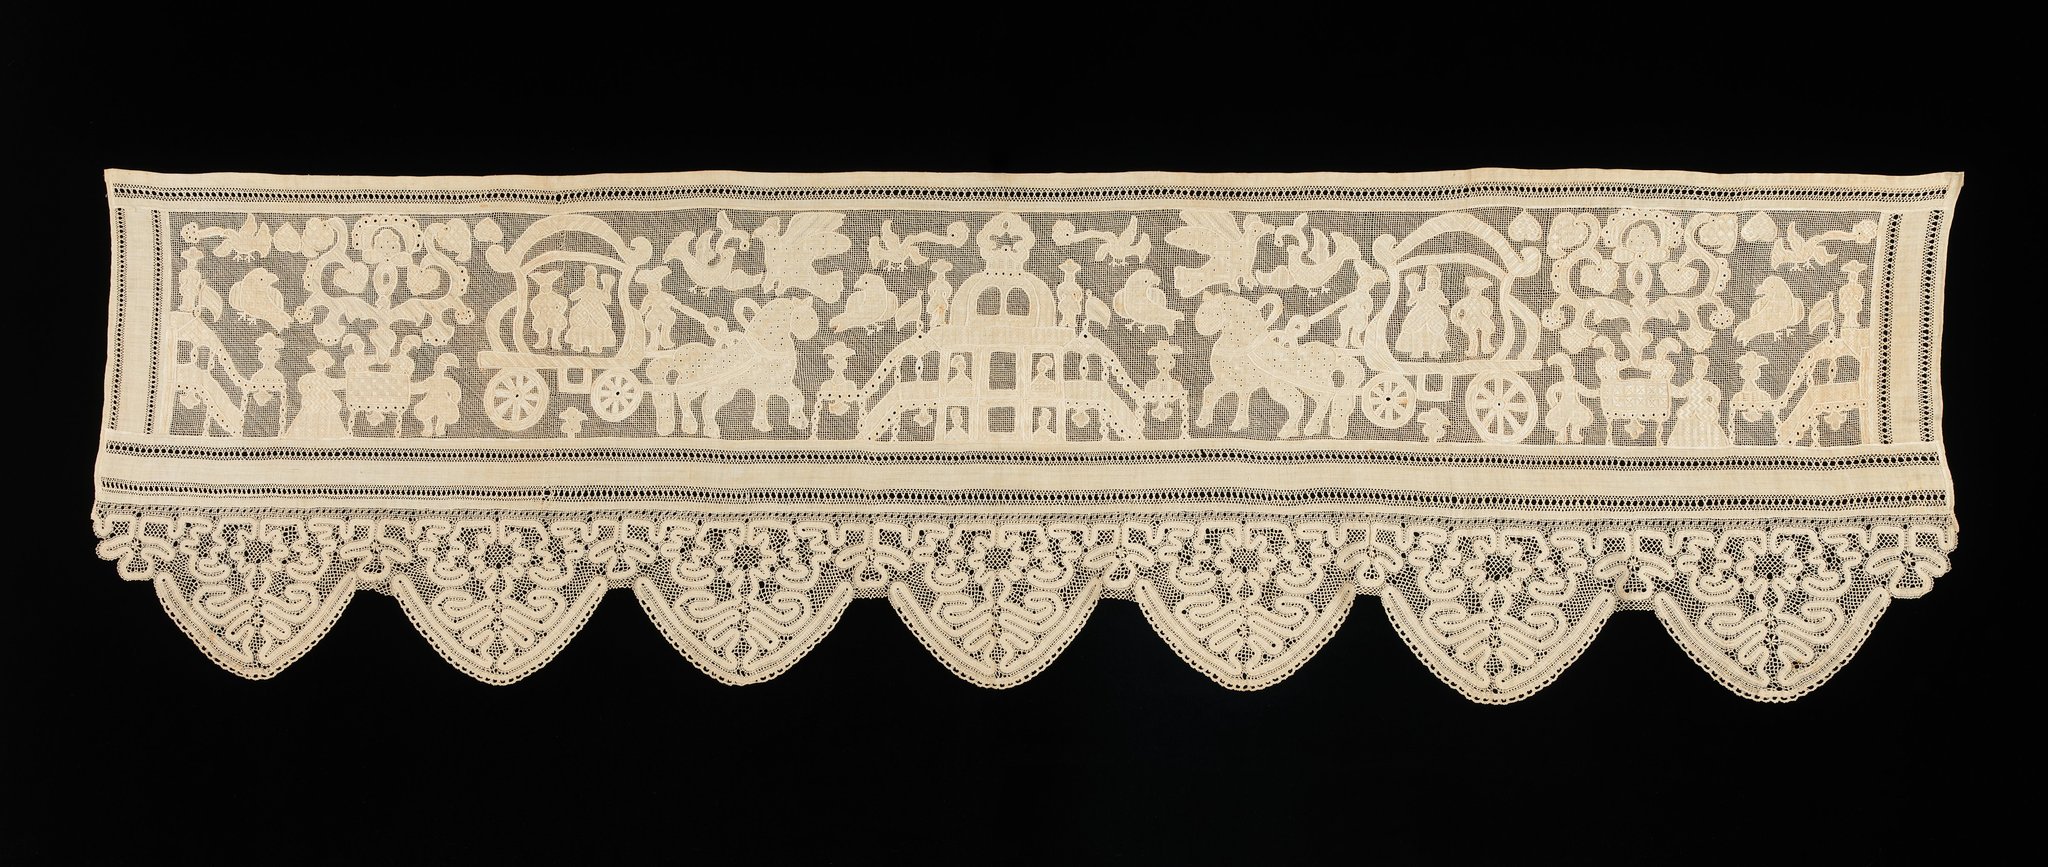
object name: border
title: Bed curtain border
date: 1801-1825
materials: linen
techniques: lace, embroidery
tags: human figures,birds,carriages